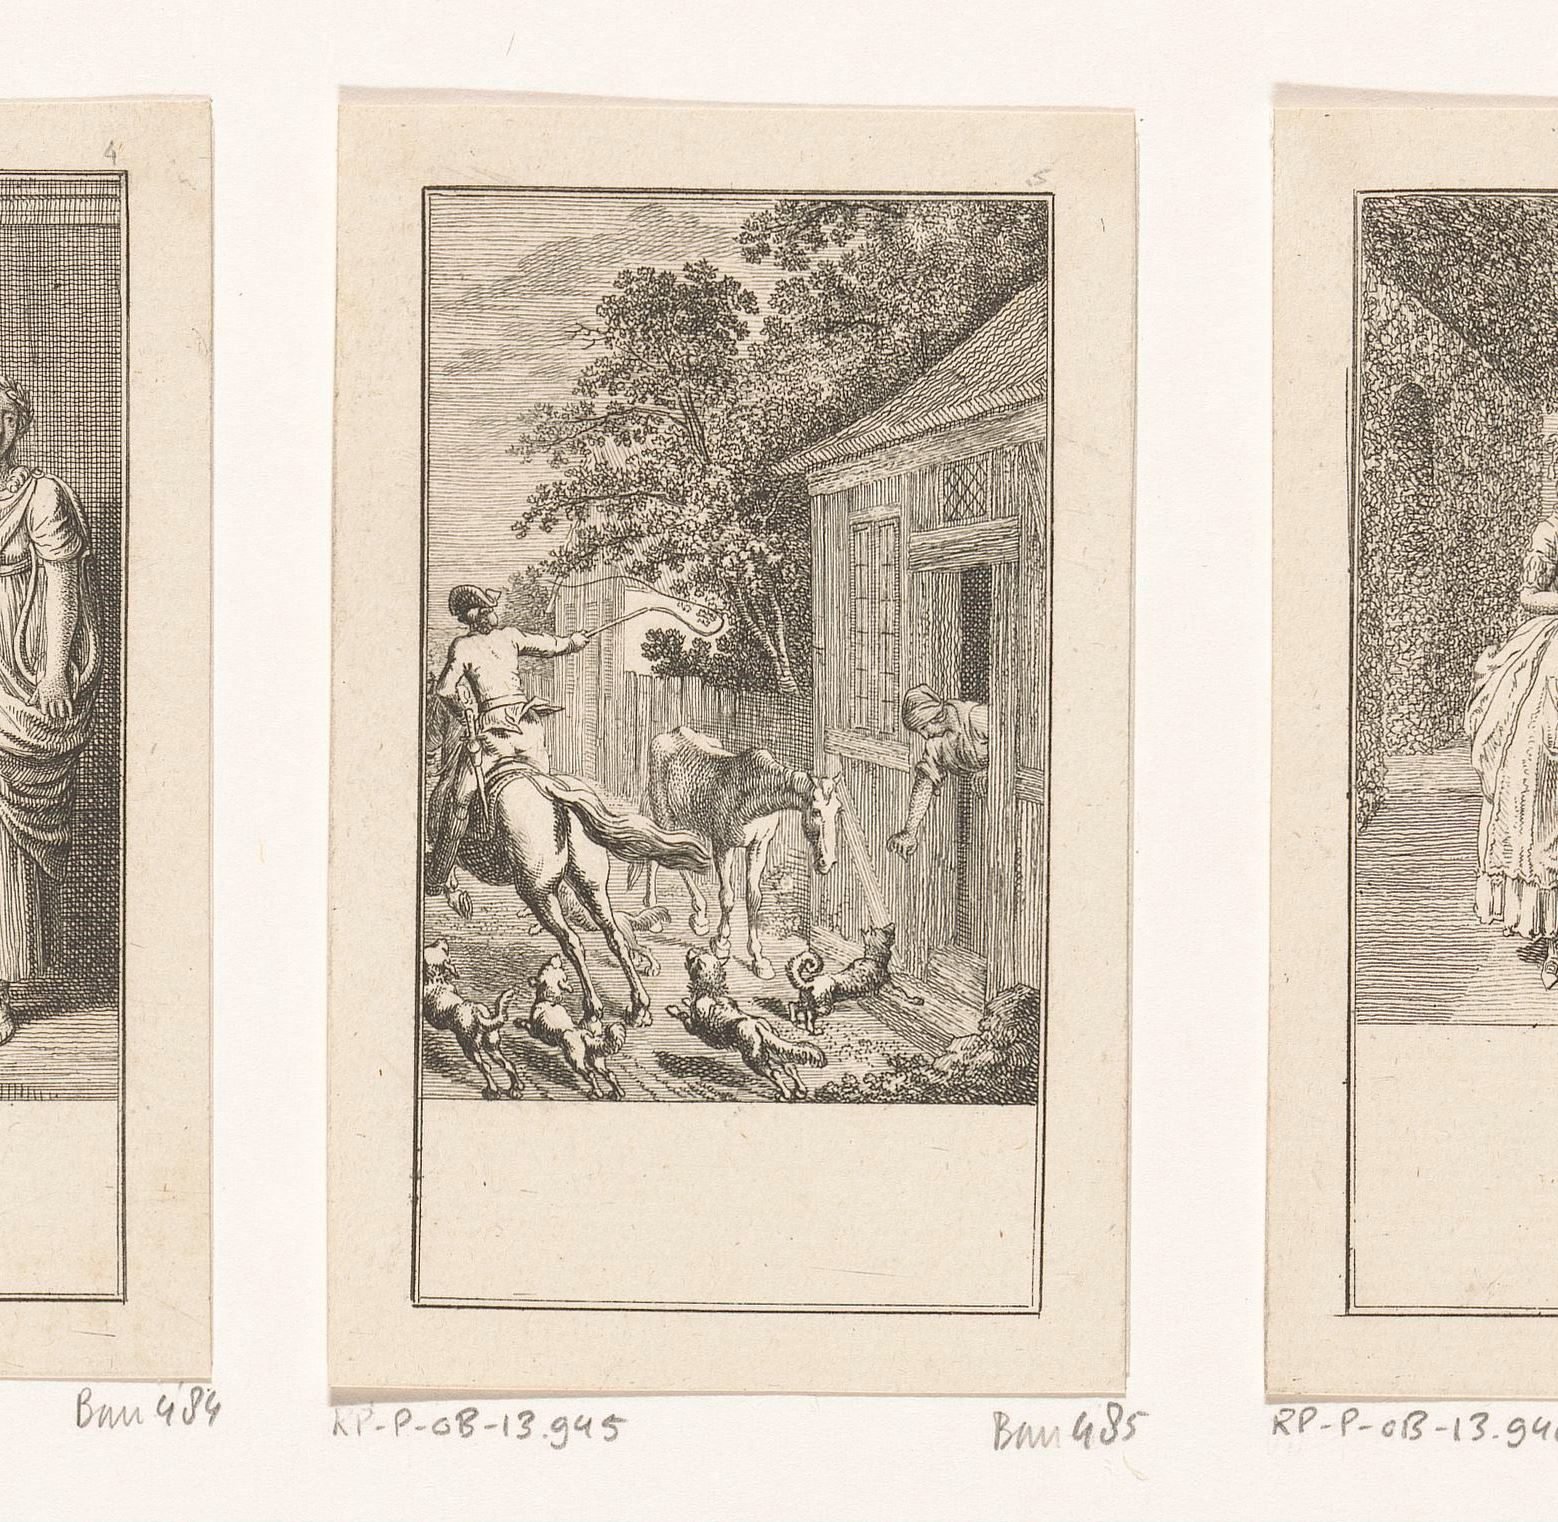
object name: print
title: Galopperende ruiter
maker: daniel nikolaus chodowiecki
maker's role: draughtsman, print maker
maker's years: 1726-1801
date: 1778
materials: paper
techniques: etching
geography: berlin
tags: riding a horse, ass, or mule; rider, horseman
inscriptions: collector's mark: Lugt 2228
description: Vijfde prent uit een serie van twaalf moralistische en satirische voorstellingen. De scènes werden op een plaat geëtst. Een latere staat van deze serie is gebruikt in: Launburger genealogischen Kalender auf das Jahr 1779. Deze serie is een herhaling van een eerdere serie met onderschriften in het Duits (zie: RP-P-OB-13.938) en het Frans (zie: RP-P-OB-13.393 en RP-P-OB-13.940).